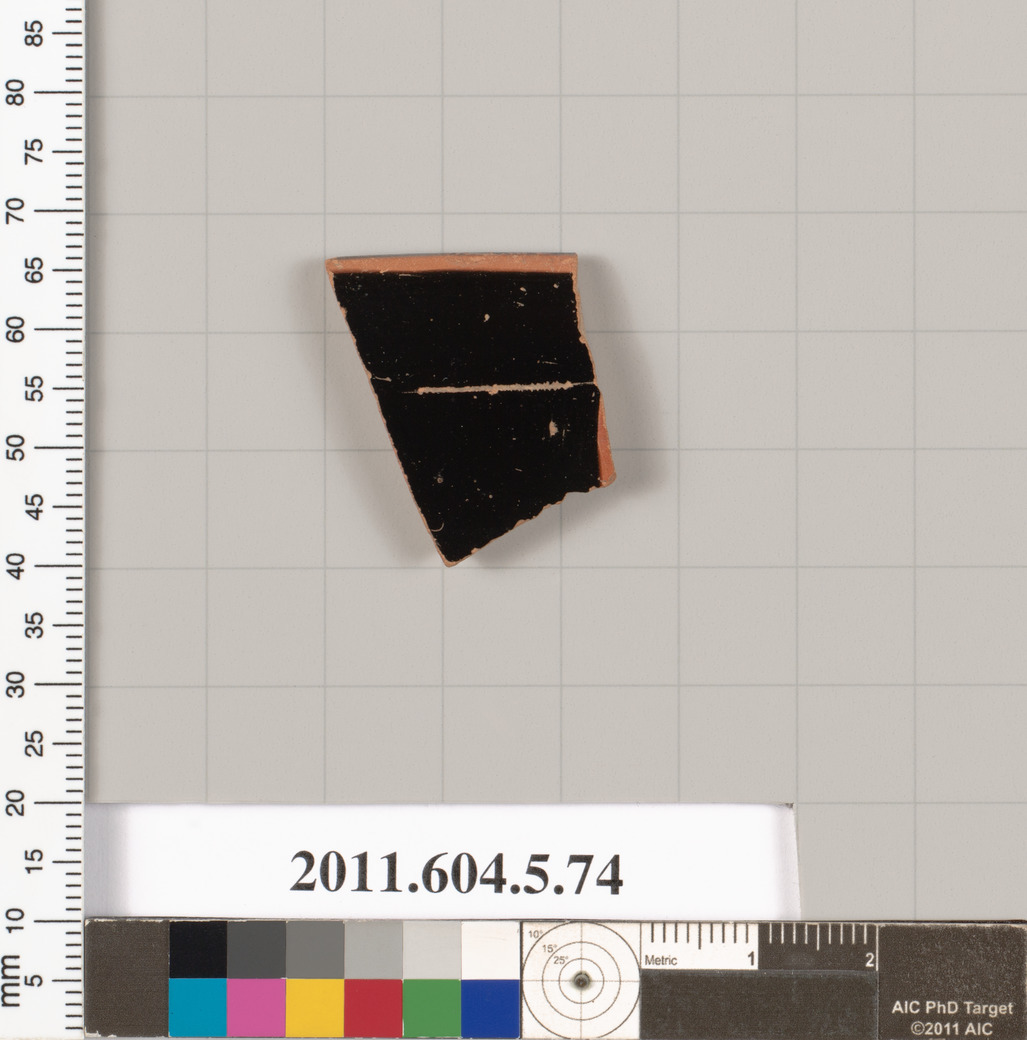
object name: kylix fragment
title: Terracotta rim fragment of a kylix (drinking cup)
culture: greek, attic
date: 500-451 BCE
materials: terracotta